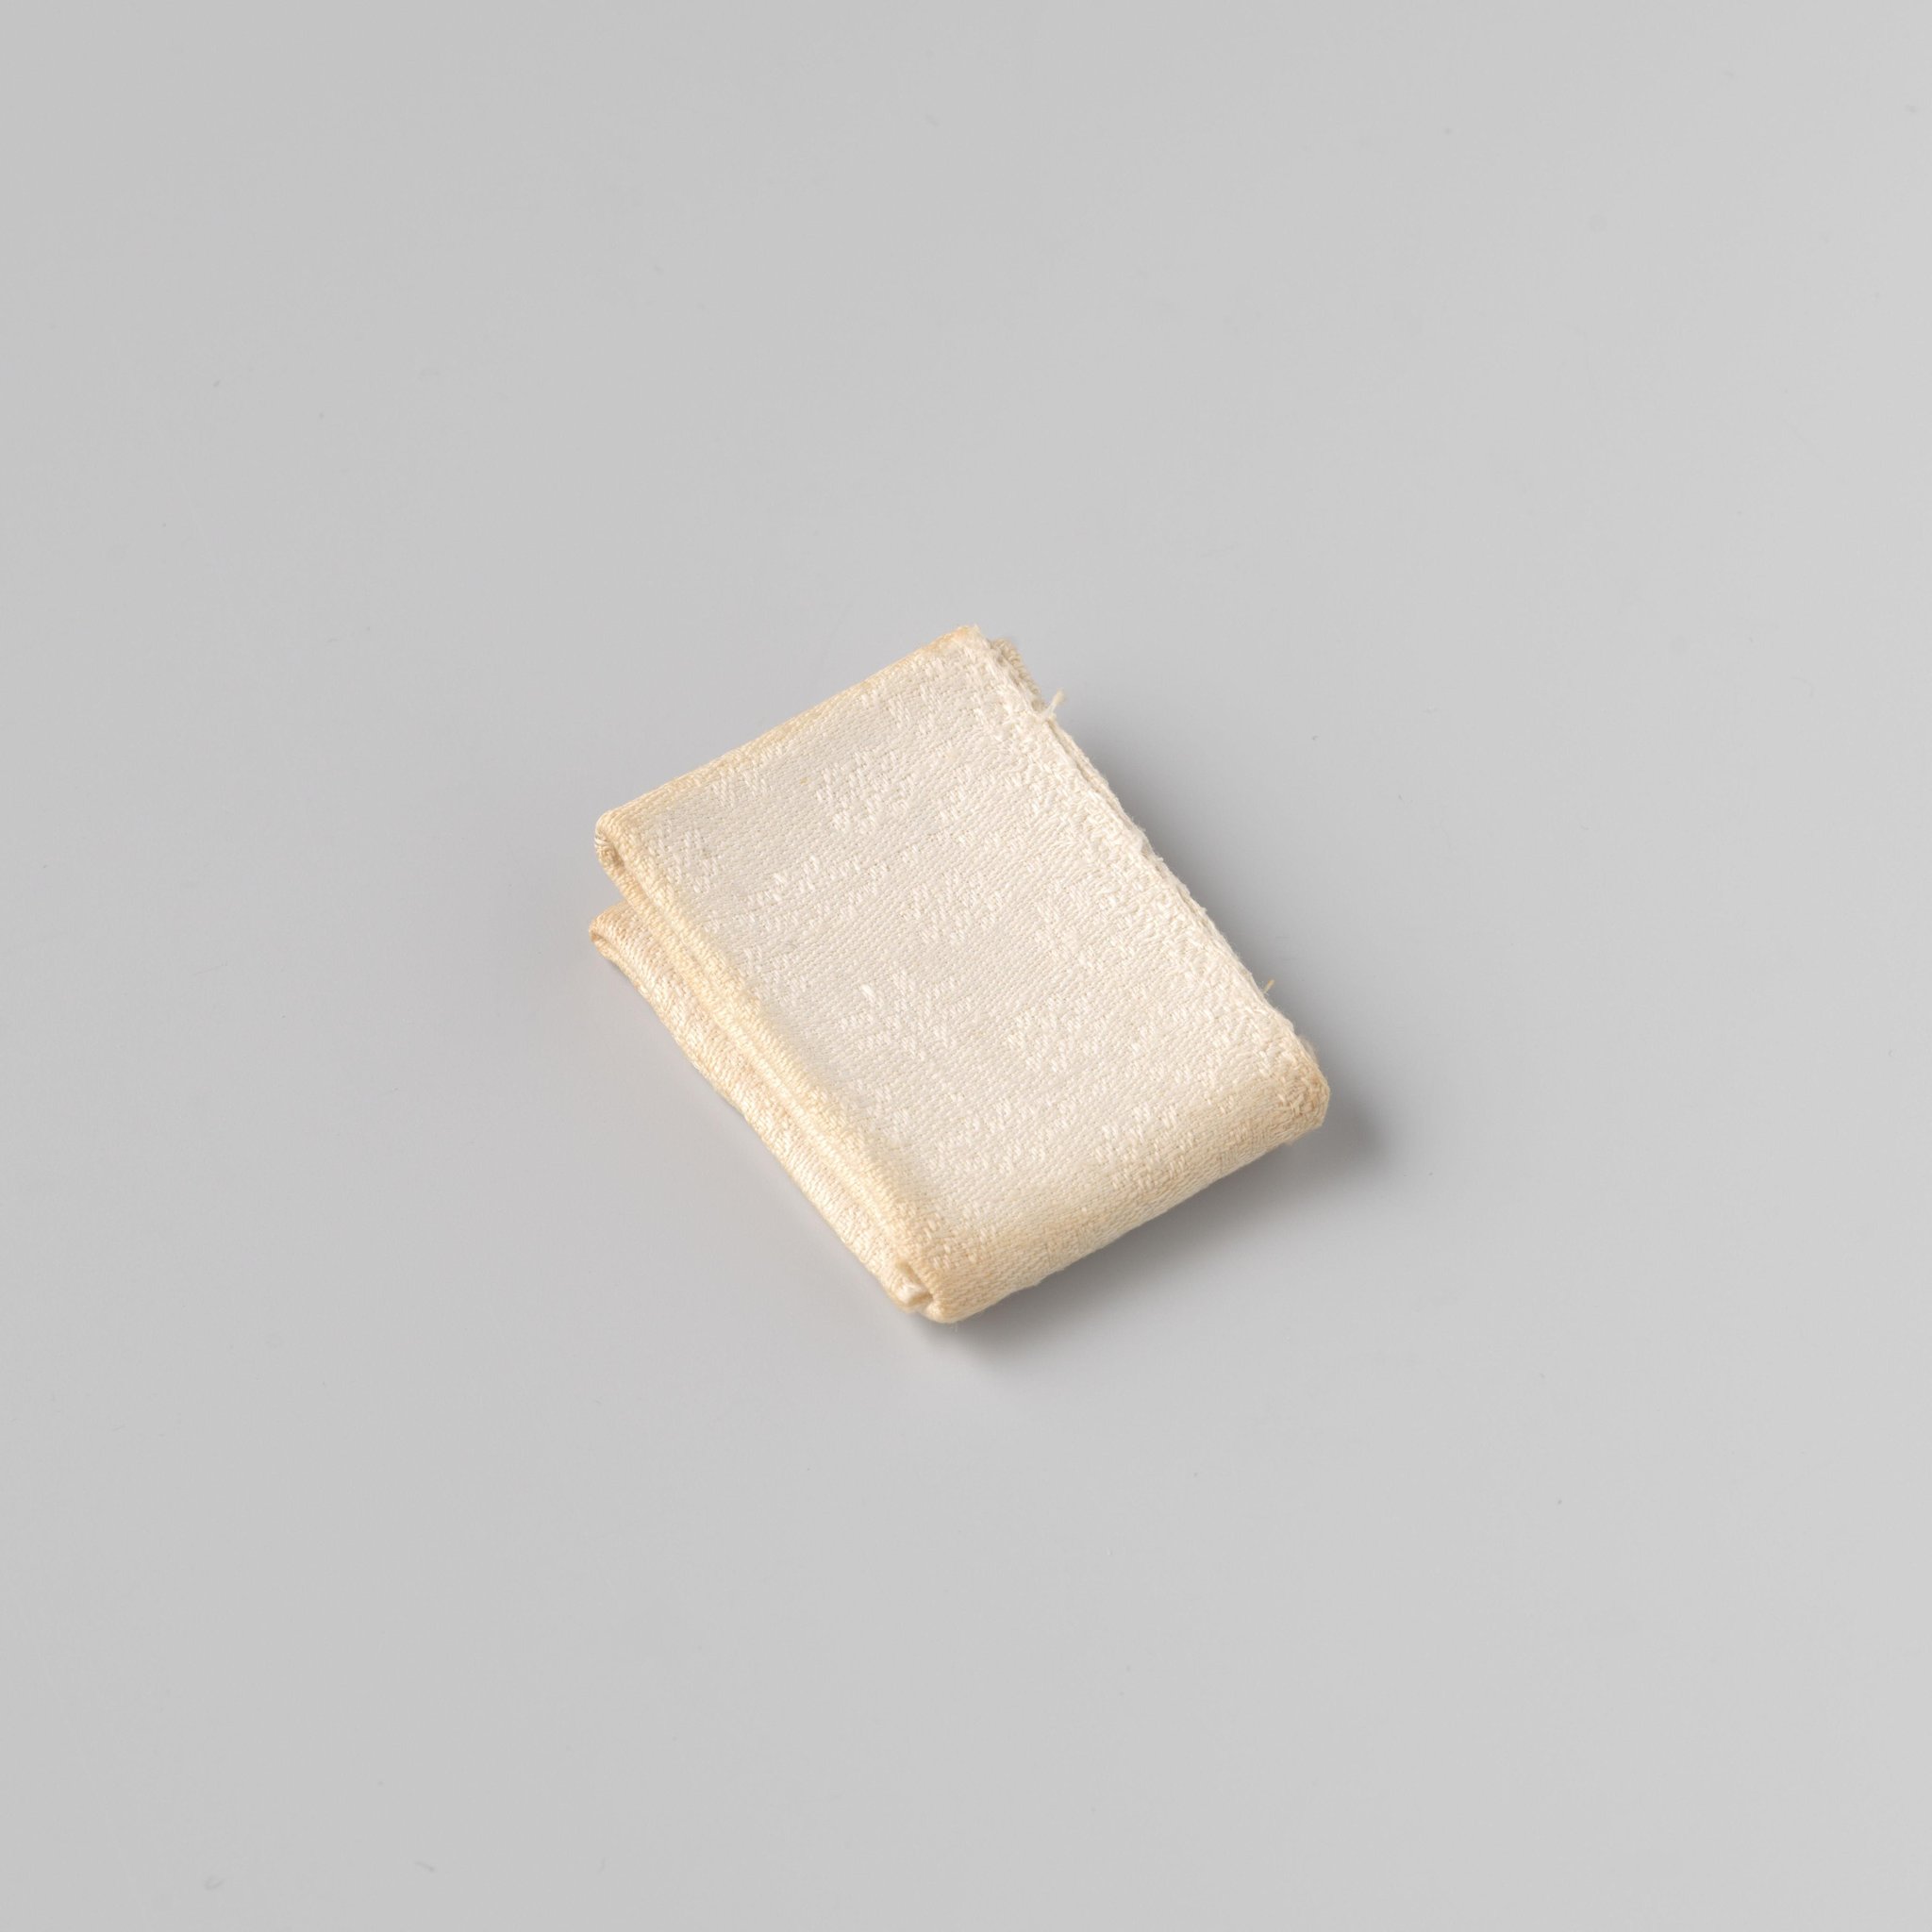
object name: napkin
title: Linnen servet van damastweefsel met pellenpatroon (motief I), geen zomen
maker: Anonymous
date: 1690-1710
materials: linen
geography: amsterdam